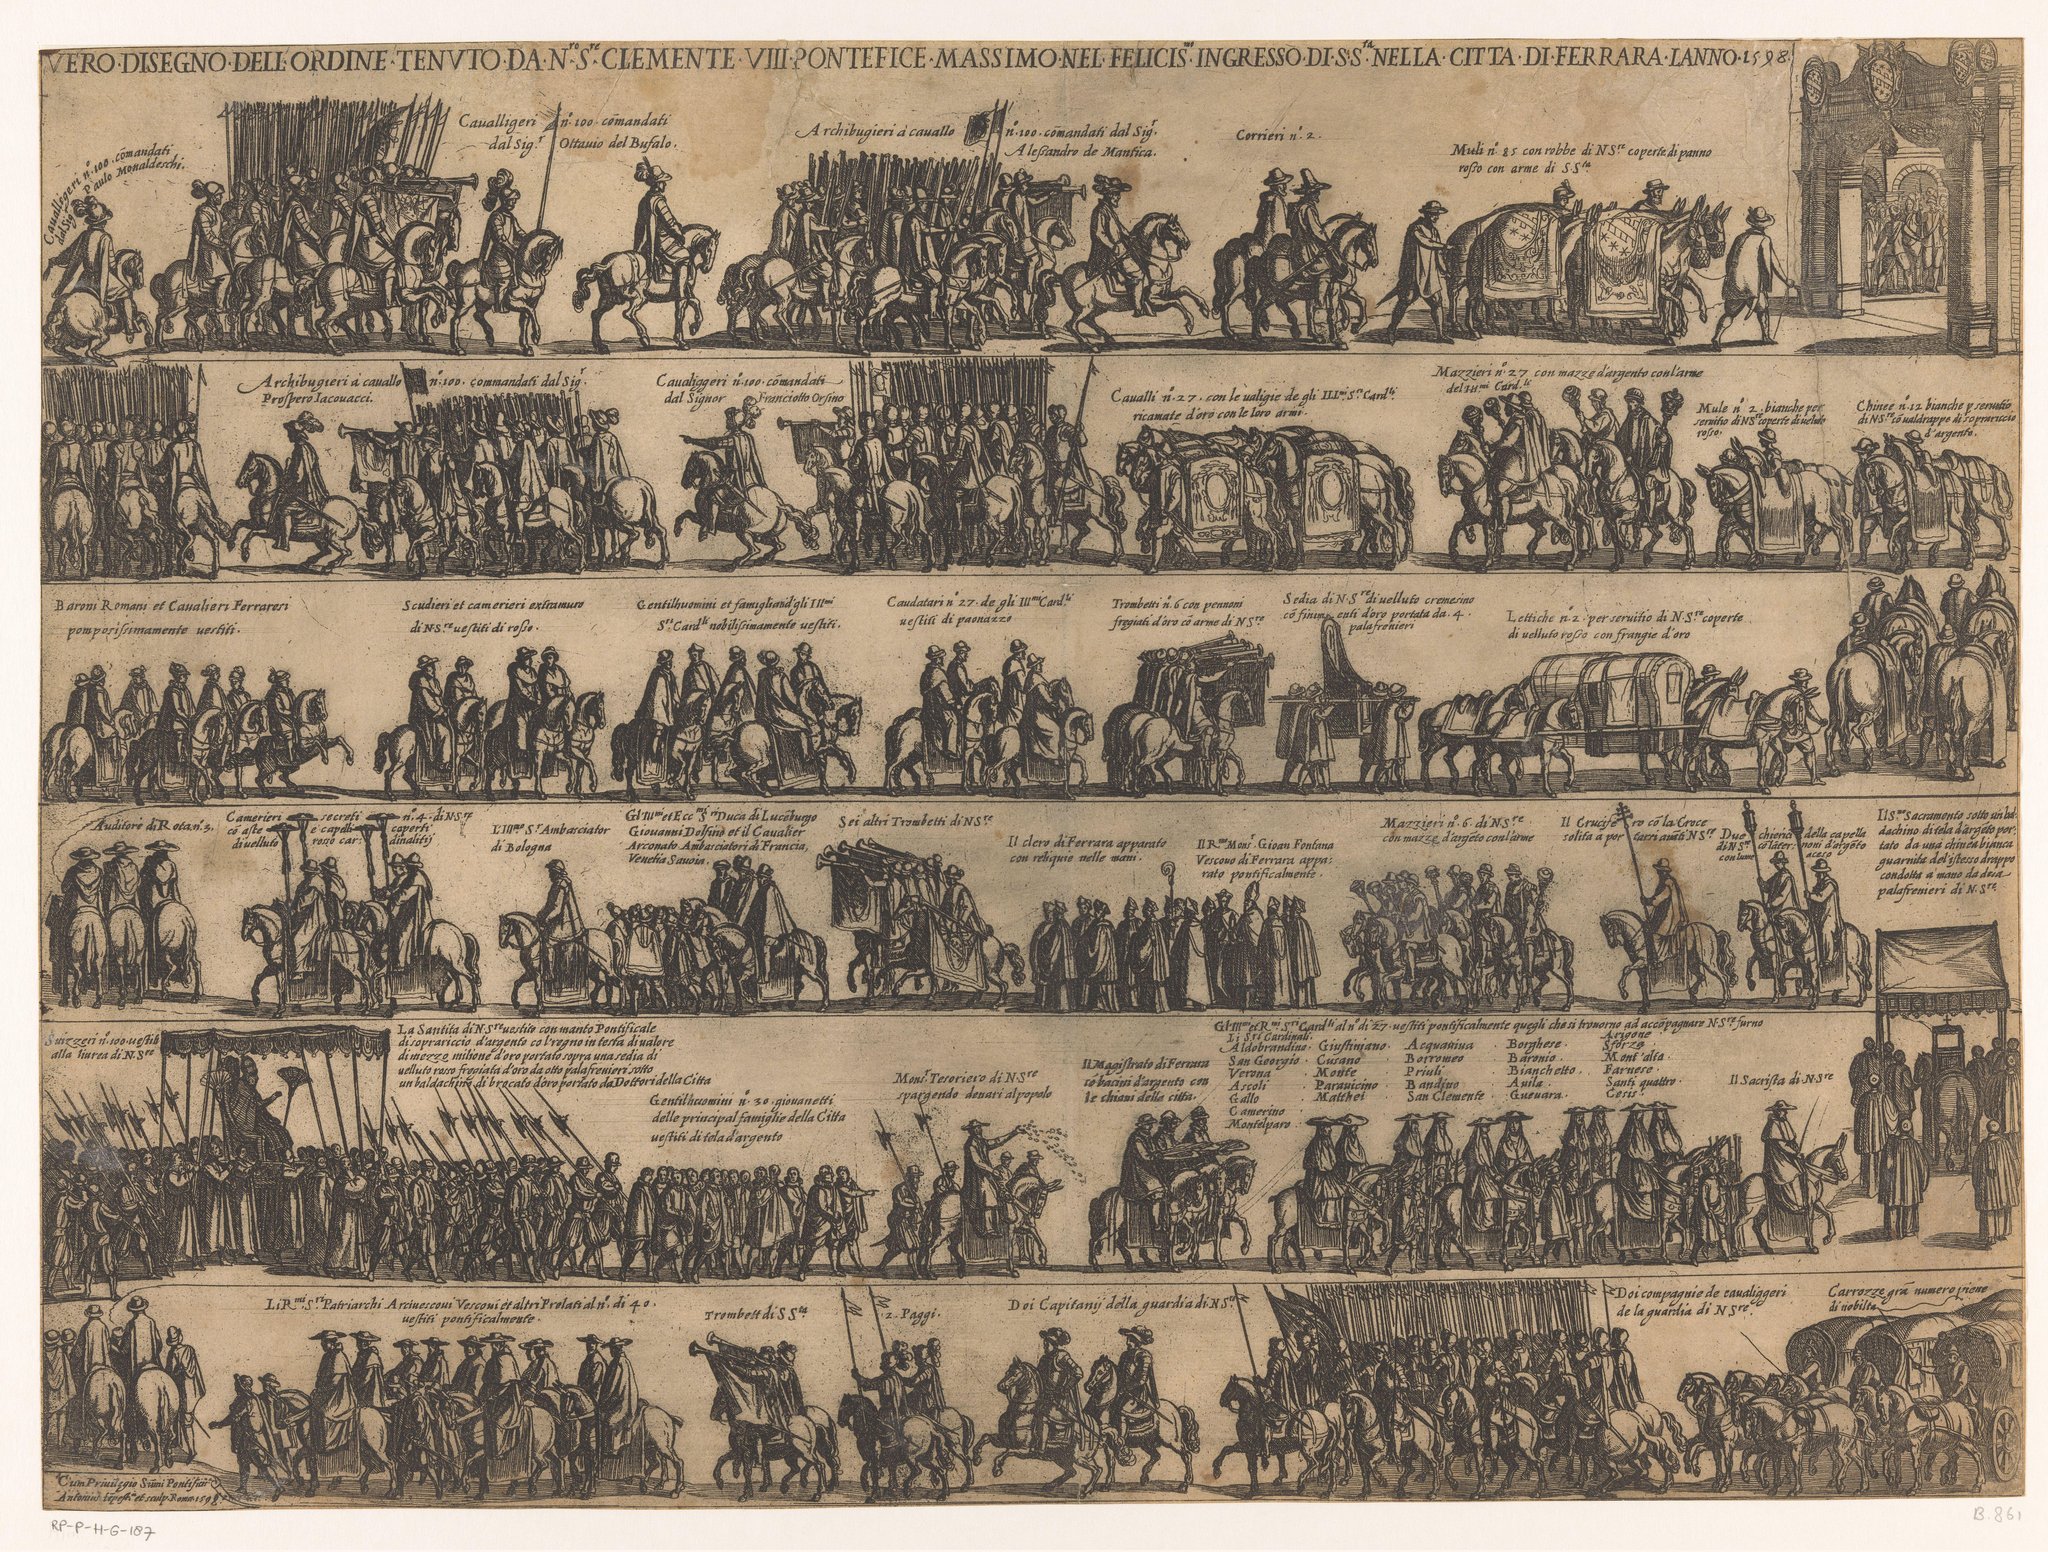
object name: print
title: Processie voor intocht van paus Clemens VIII in Ferrara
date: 1598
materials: paper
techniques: etching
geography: rome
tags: clemens viii, ceremonial procession, parade, pageant ~ pope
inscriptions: collector's mark: Lugt 11, collector's mark: ‘Hinloopen’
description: Een processie met soldaten, kardinalen, paarden en paus Clemens VIII de stad Ferrara in. Boven elk groepje een bijschrift in het Italiaans.